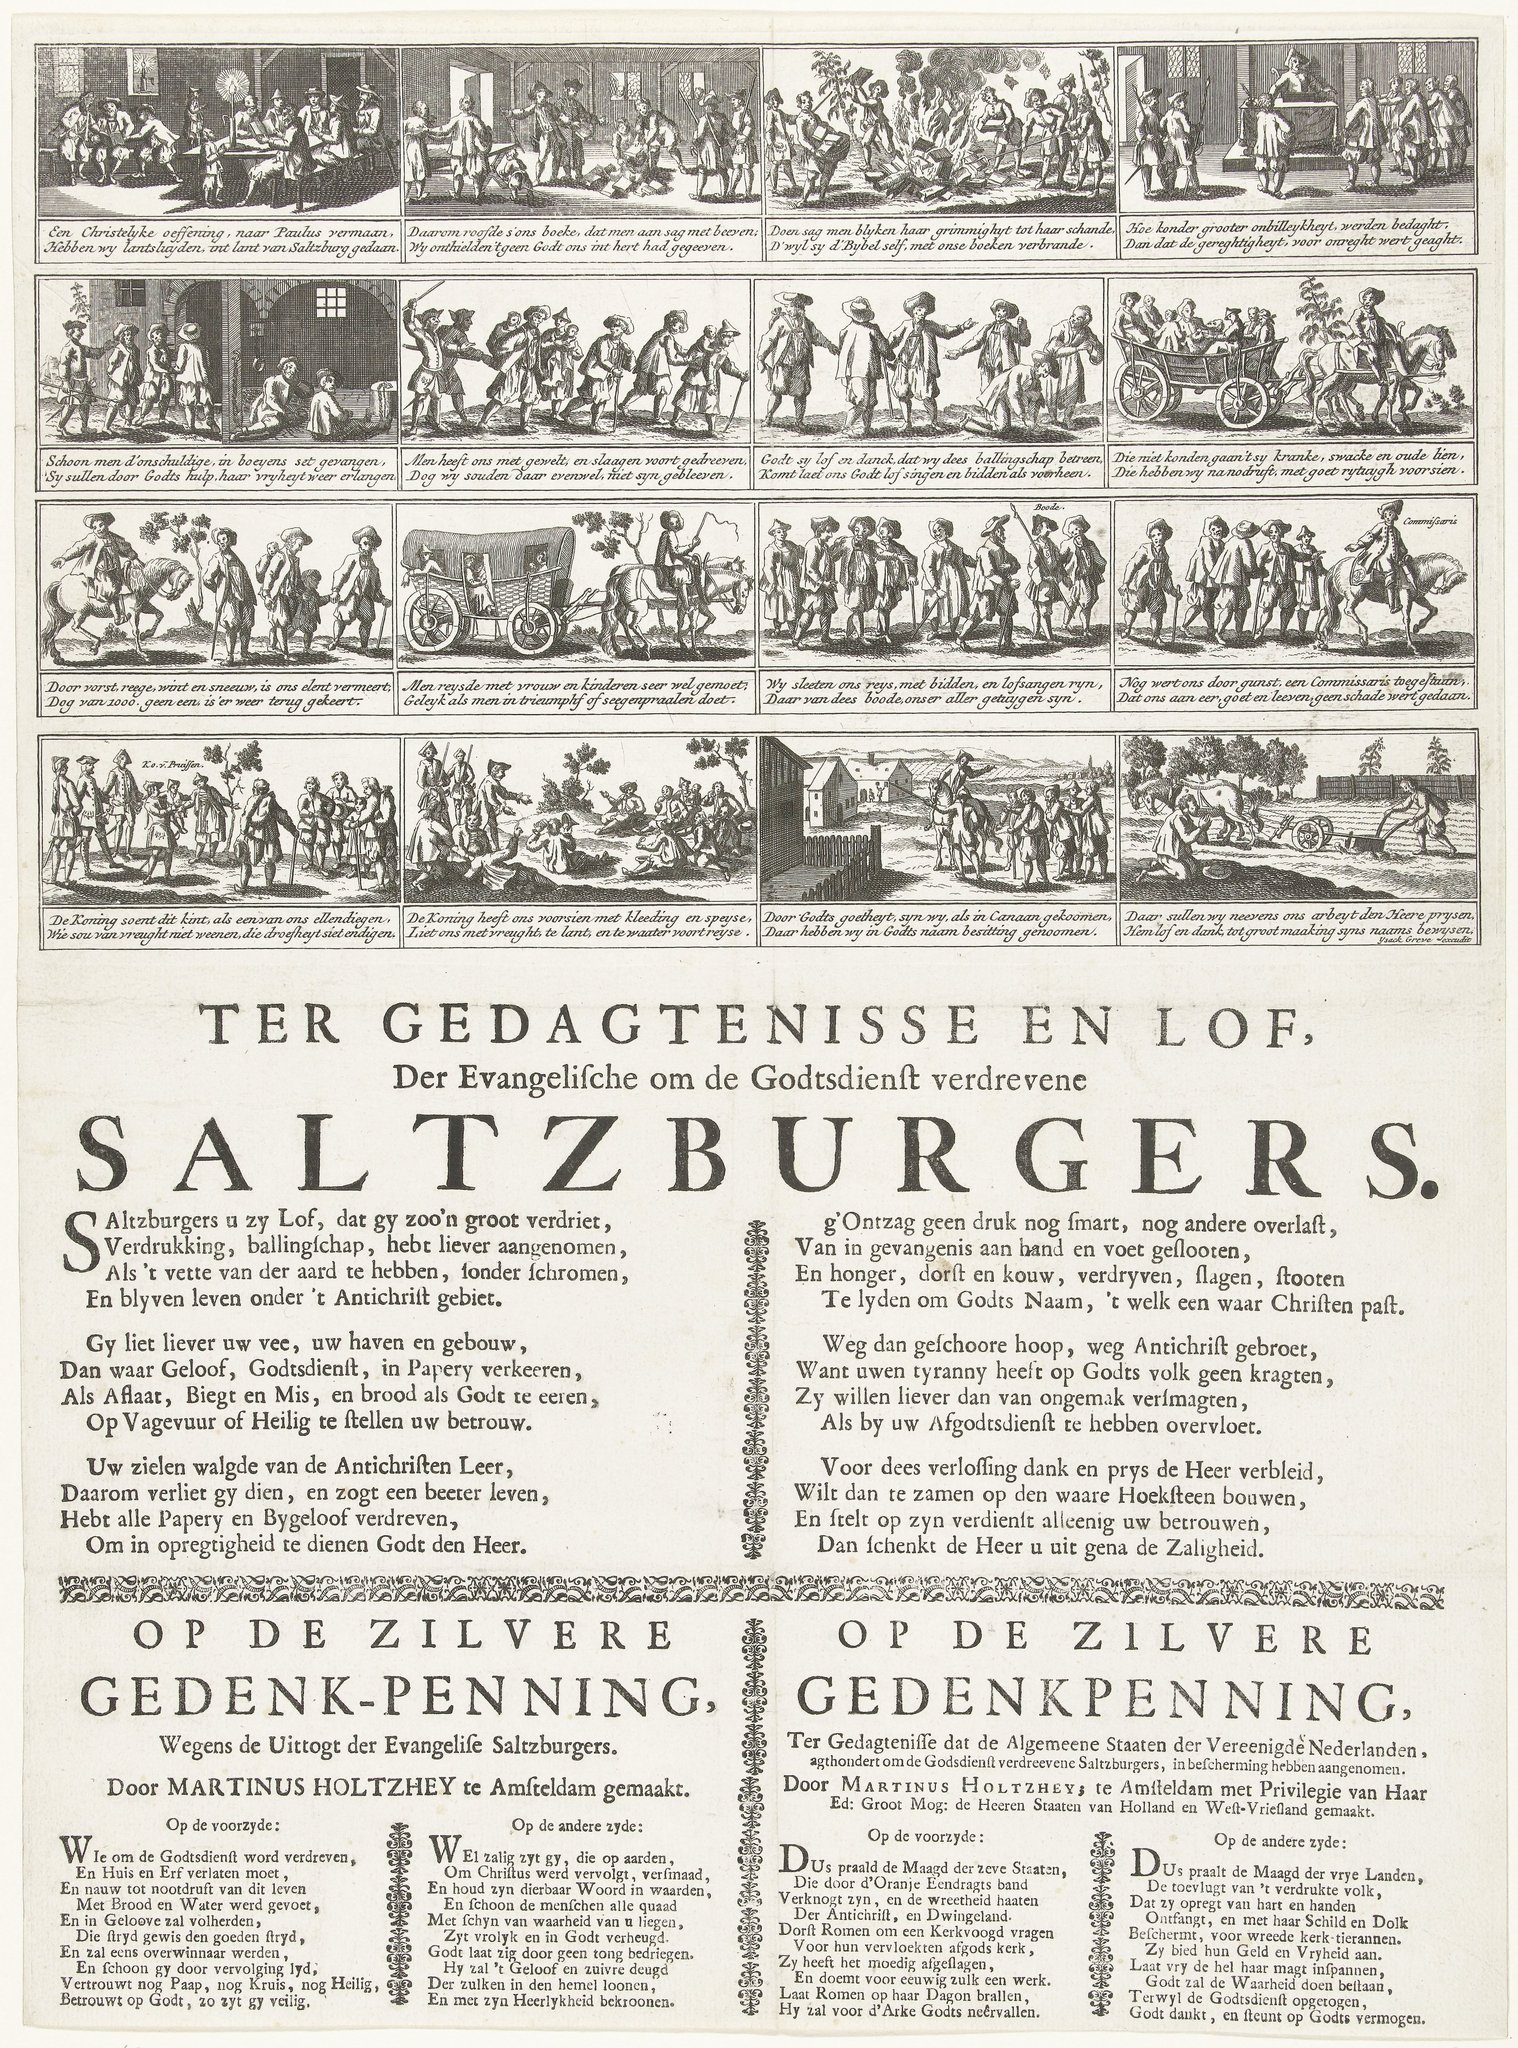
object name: print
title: Ter Gedagtenisse en Lof, Der Evangelische om de Godtsdienst verdrevene Saltzburgers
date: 1733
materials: paper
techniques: etching, letterpress printing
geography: northern netherlands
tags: persecuted believers (hiding), e.g. huguenots, pilgrim fathers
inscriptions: collector's mark: Lugt 2228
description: Blad met bovenaan zestien voorstellingen van de Salzburgse emigranten: de vervolging van deze lutherse Salzburgers in hun eigen land, hun gedwongen vertrek en de opname van deze vluchtelingen in Nederland in de jaren 1732-1733. Op het blad onder de plaat een vers en de beschrijving van twee zilveren penningen op de verdreven Salzburgers met verzen.